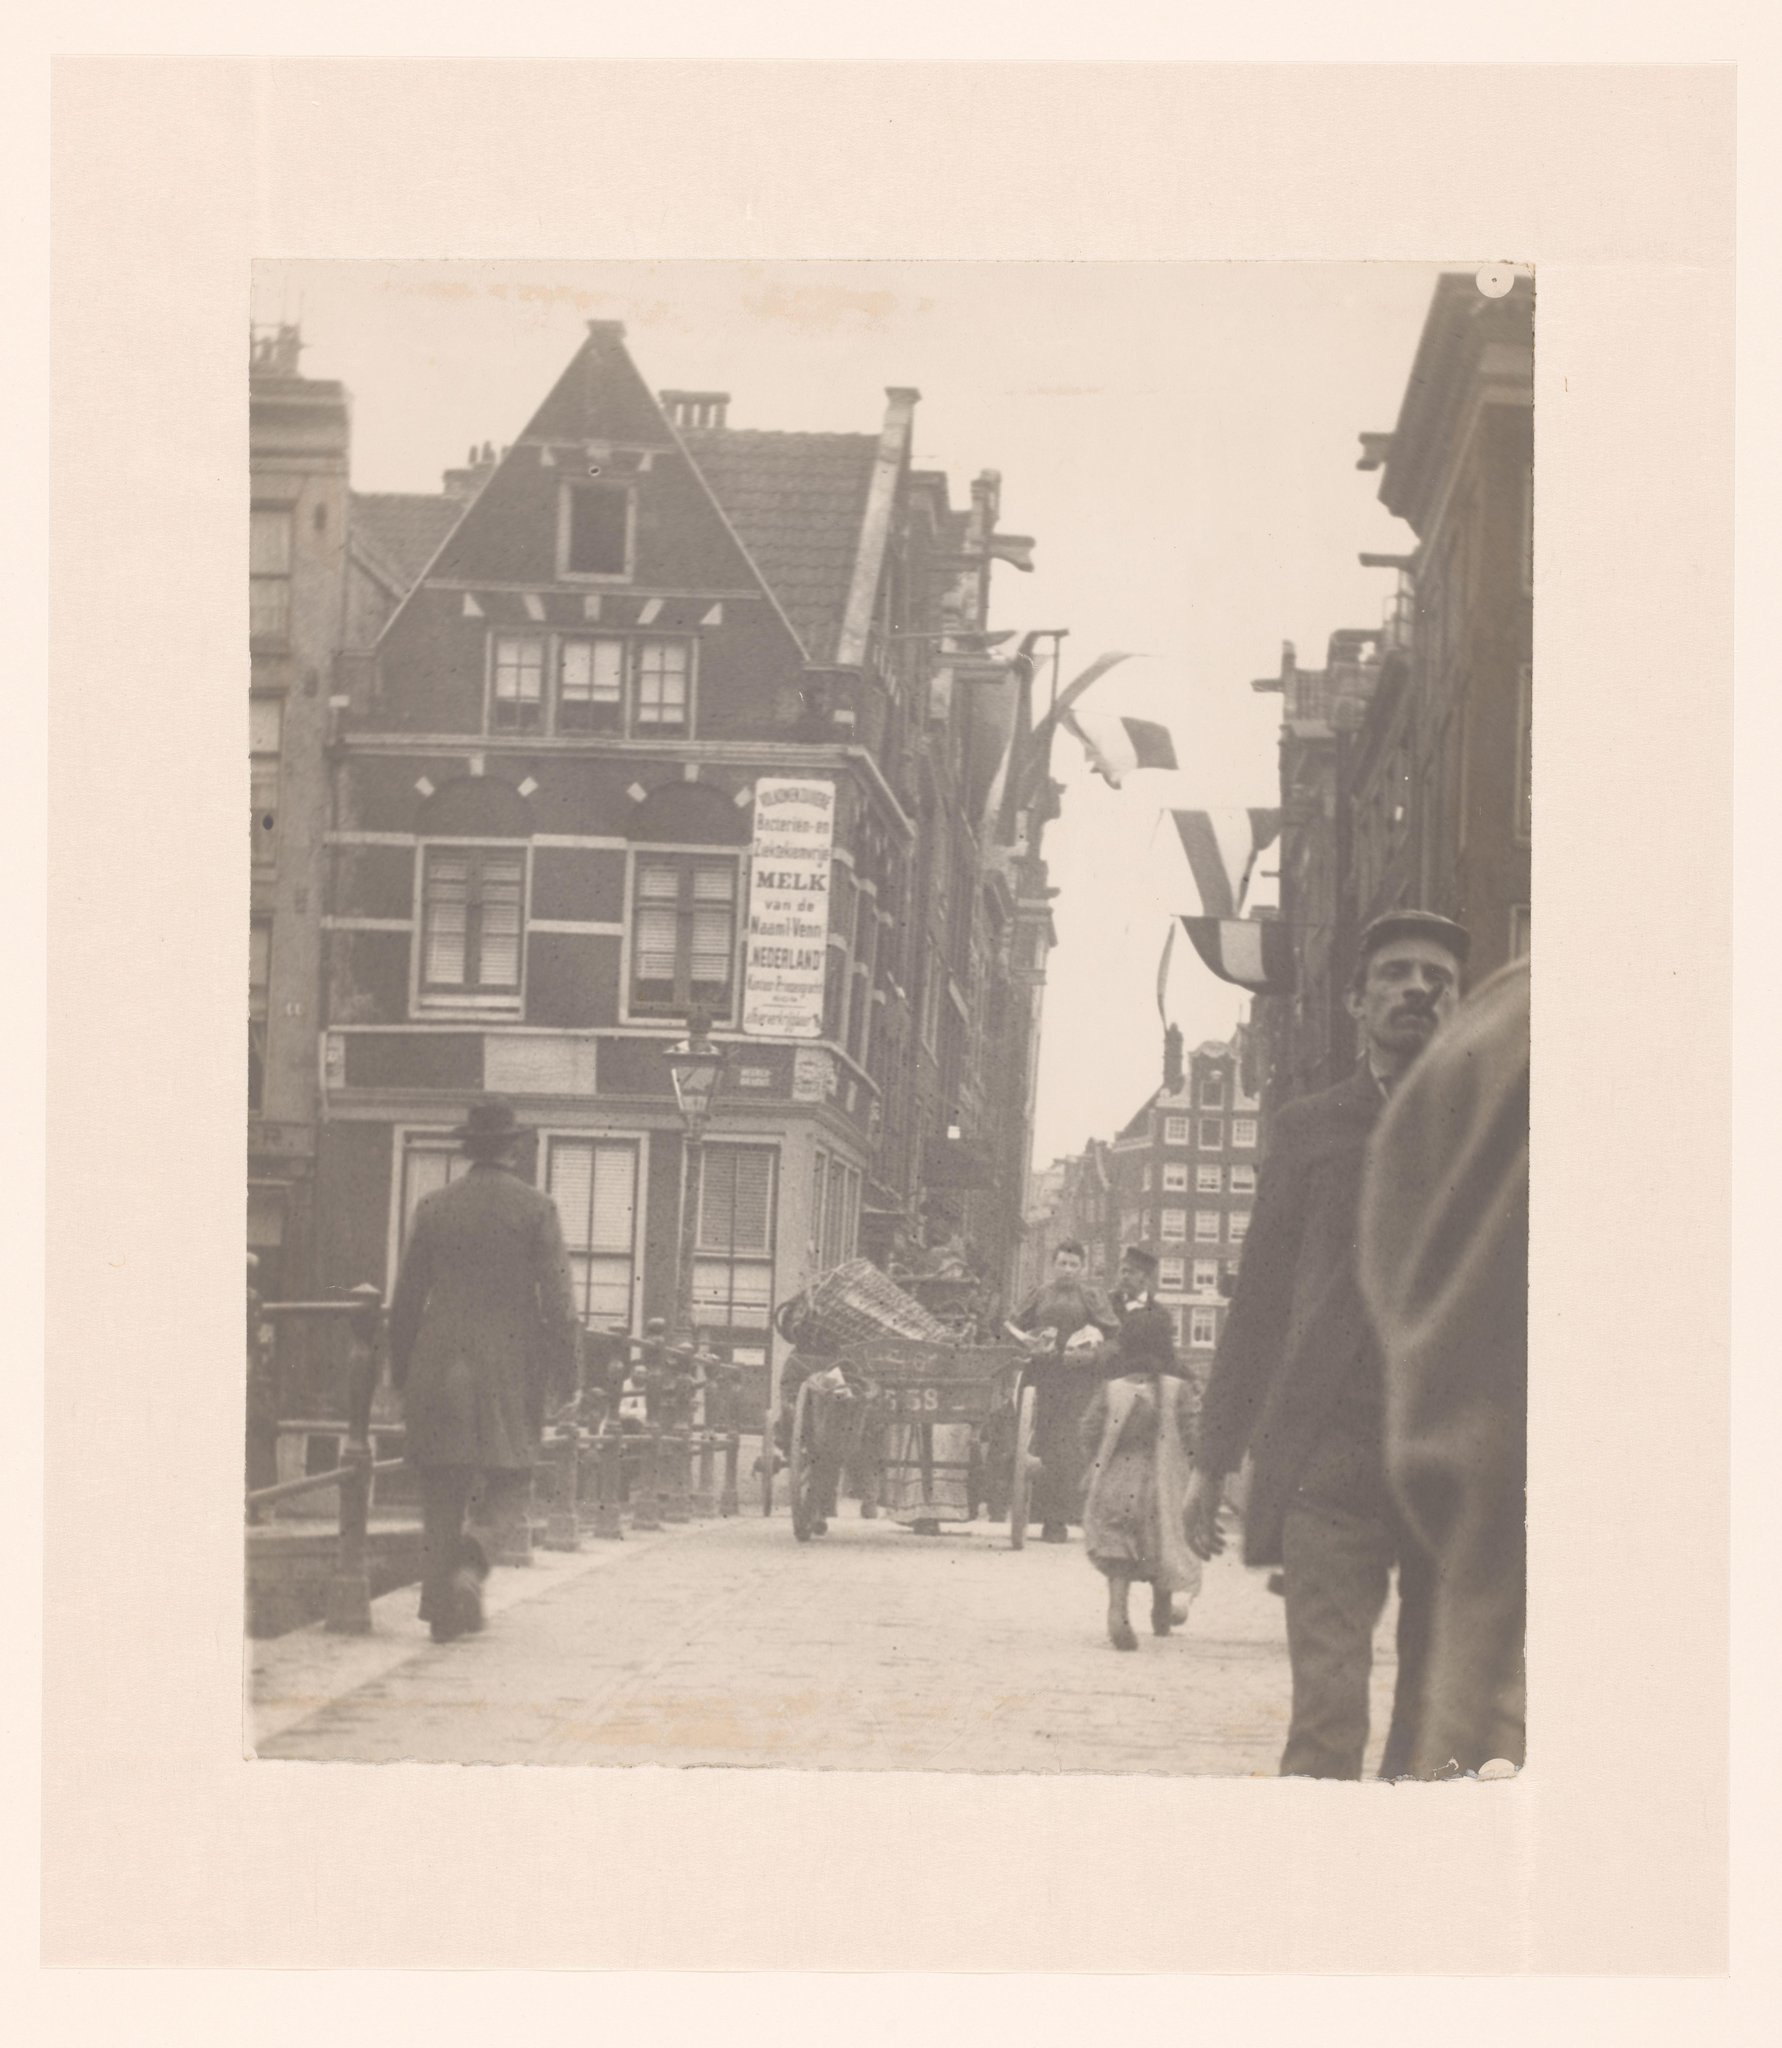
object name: photograph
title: Corner of Herengracht and Gasthuismolensteeg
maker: george hendrik breitner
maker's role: draughtsman, painter, print maker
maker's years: 1857-1923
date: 1890-1900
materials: cardboard, paper, photographic support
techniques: gelatin silver print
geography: amsterdam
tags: landscape with bridge, viaduct or aqueduct, canals, waters (in city), street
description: The painter and amateur photographer Breitner walked many miles in Amsterdam with his camera, sketchbook or paint box at hand. The absence of a central subject and abrupt cropping of his photographs deviated entirely from the norms of painting. Regardless of this, Breitner’s shots often served as inspiration for his paintings. The negatives and prints were discovered only forty years after his death.